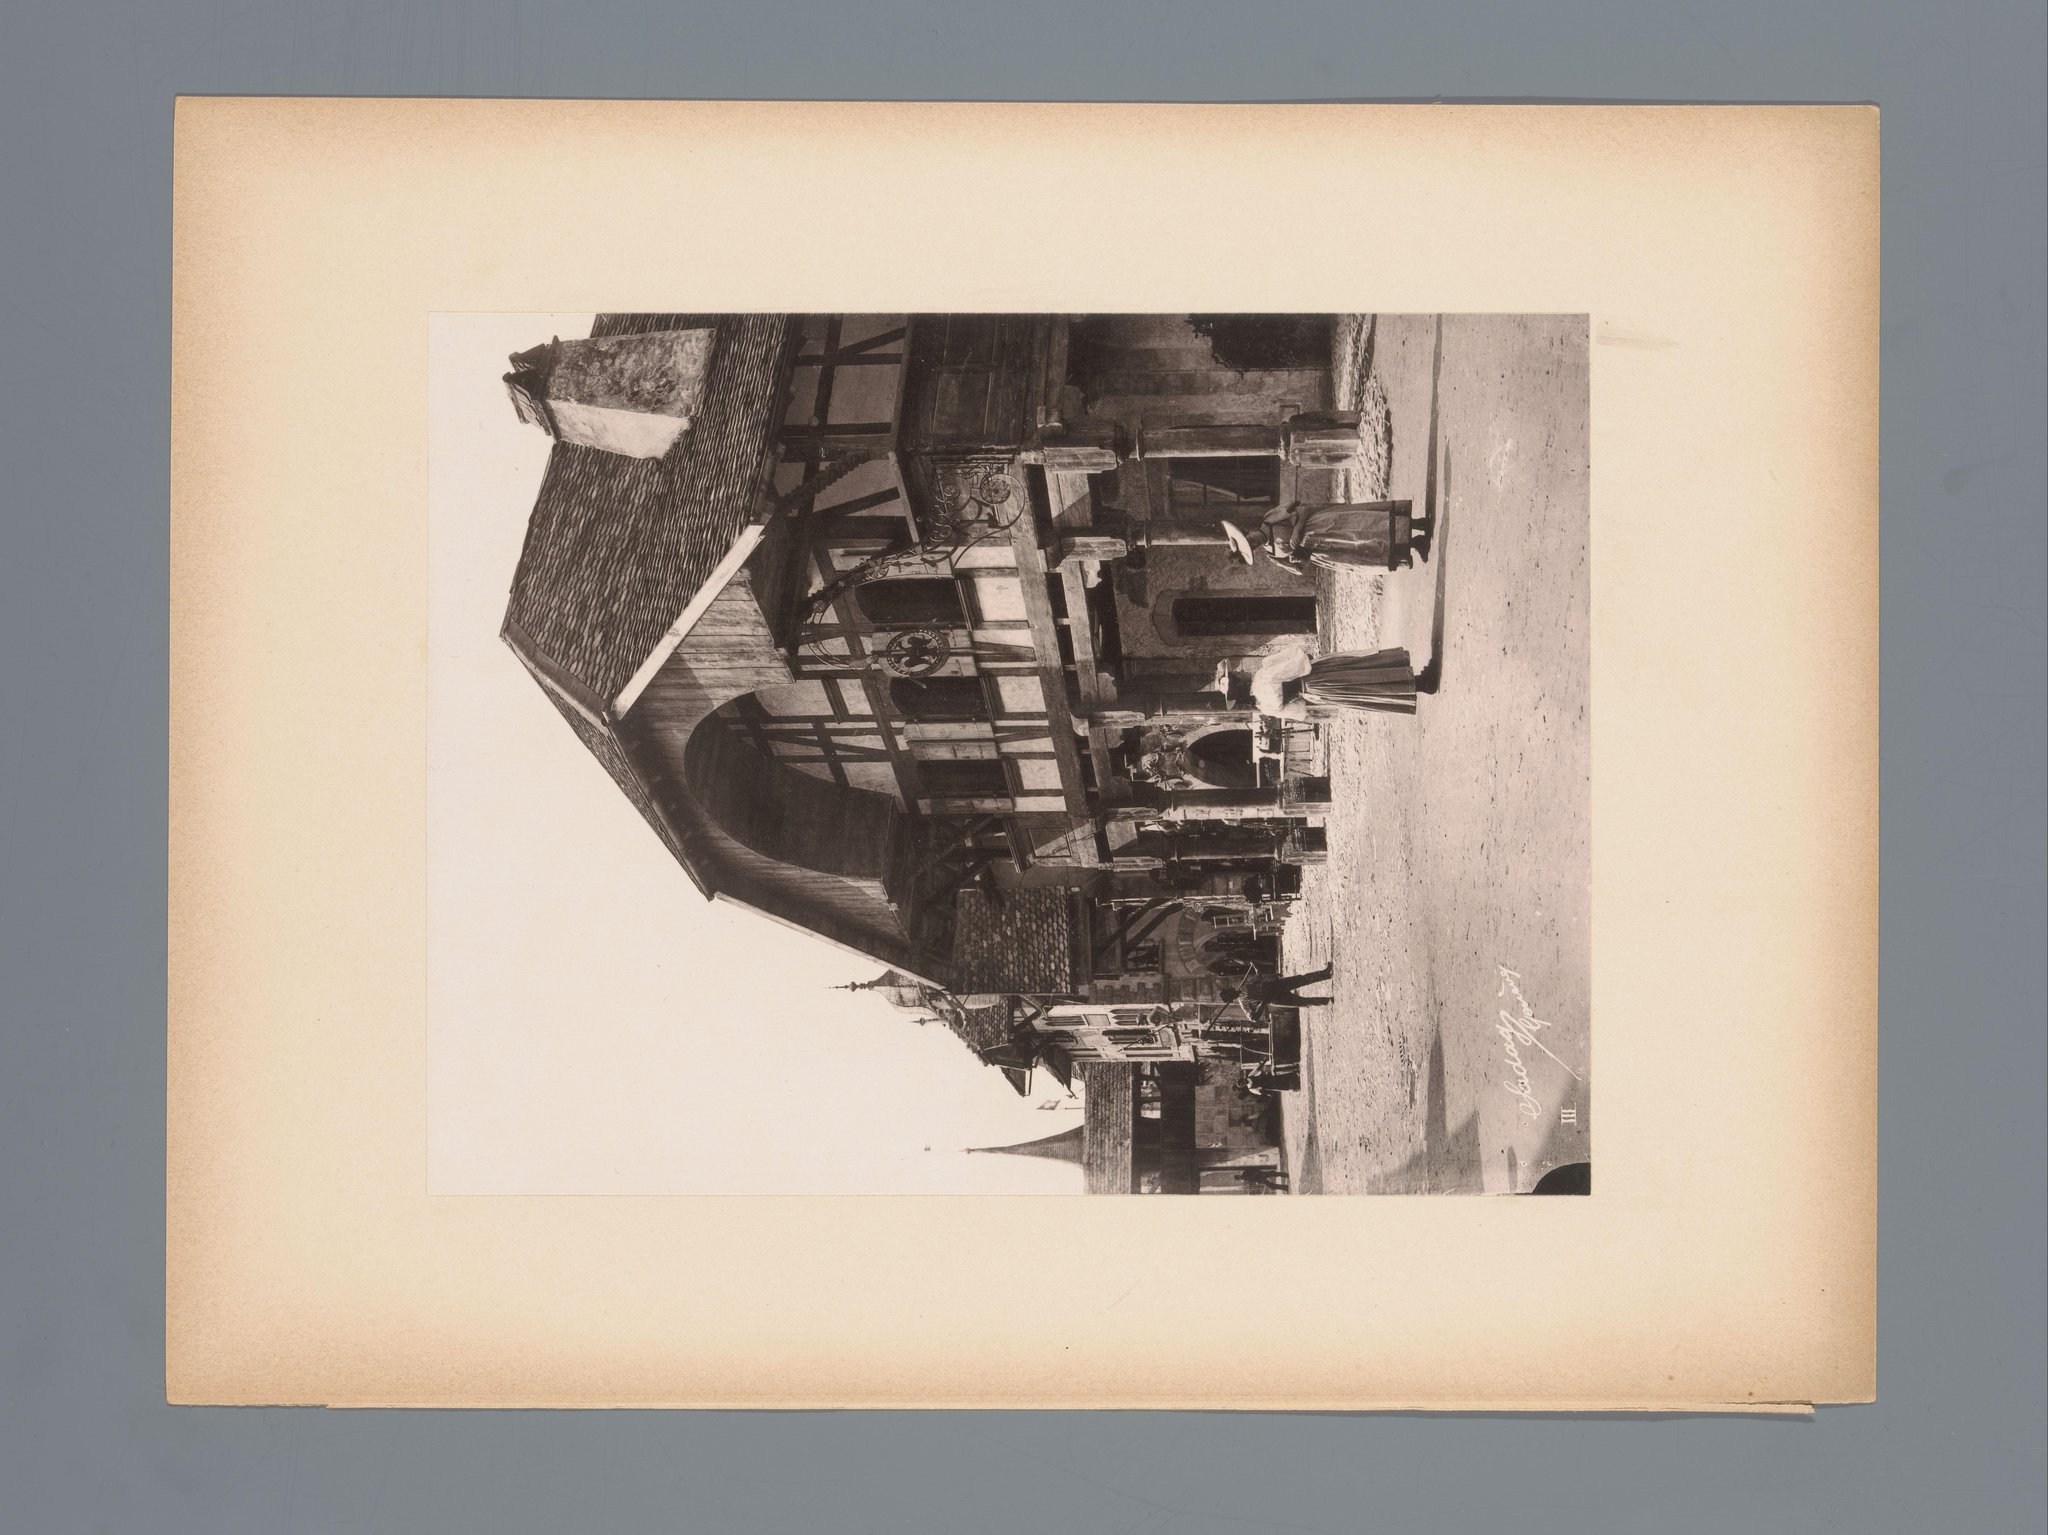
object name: photomechanical print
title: Straatgezicht in Nyon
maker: frédéric boissonnas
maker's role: fotograaf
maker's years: 1858-1946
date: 1891-1896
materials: paper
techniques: photograph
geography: geneva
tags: village street (+ city(-scape) with figures, staffage)